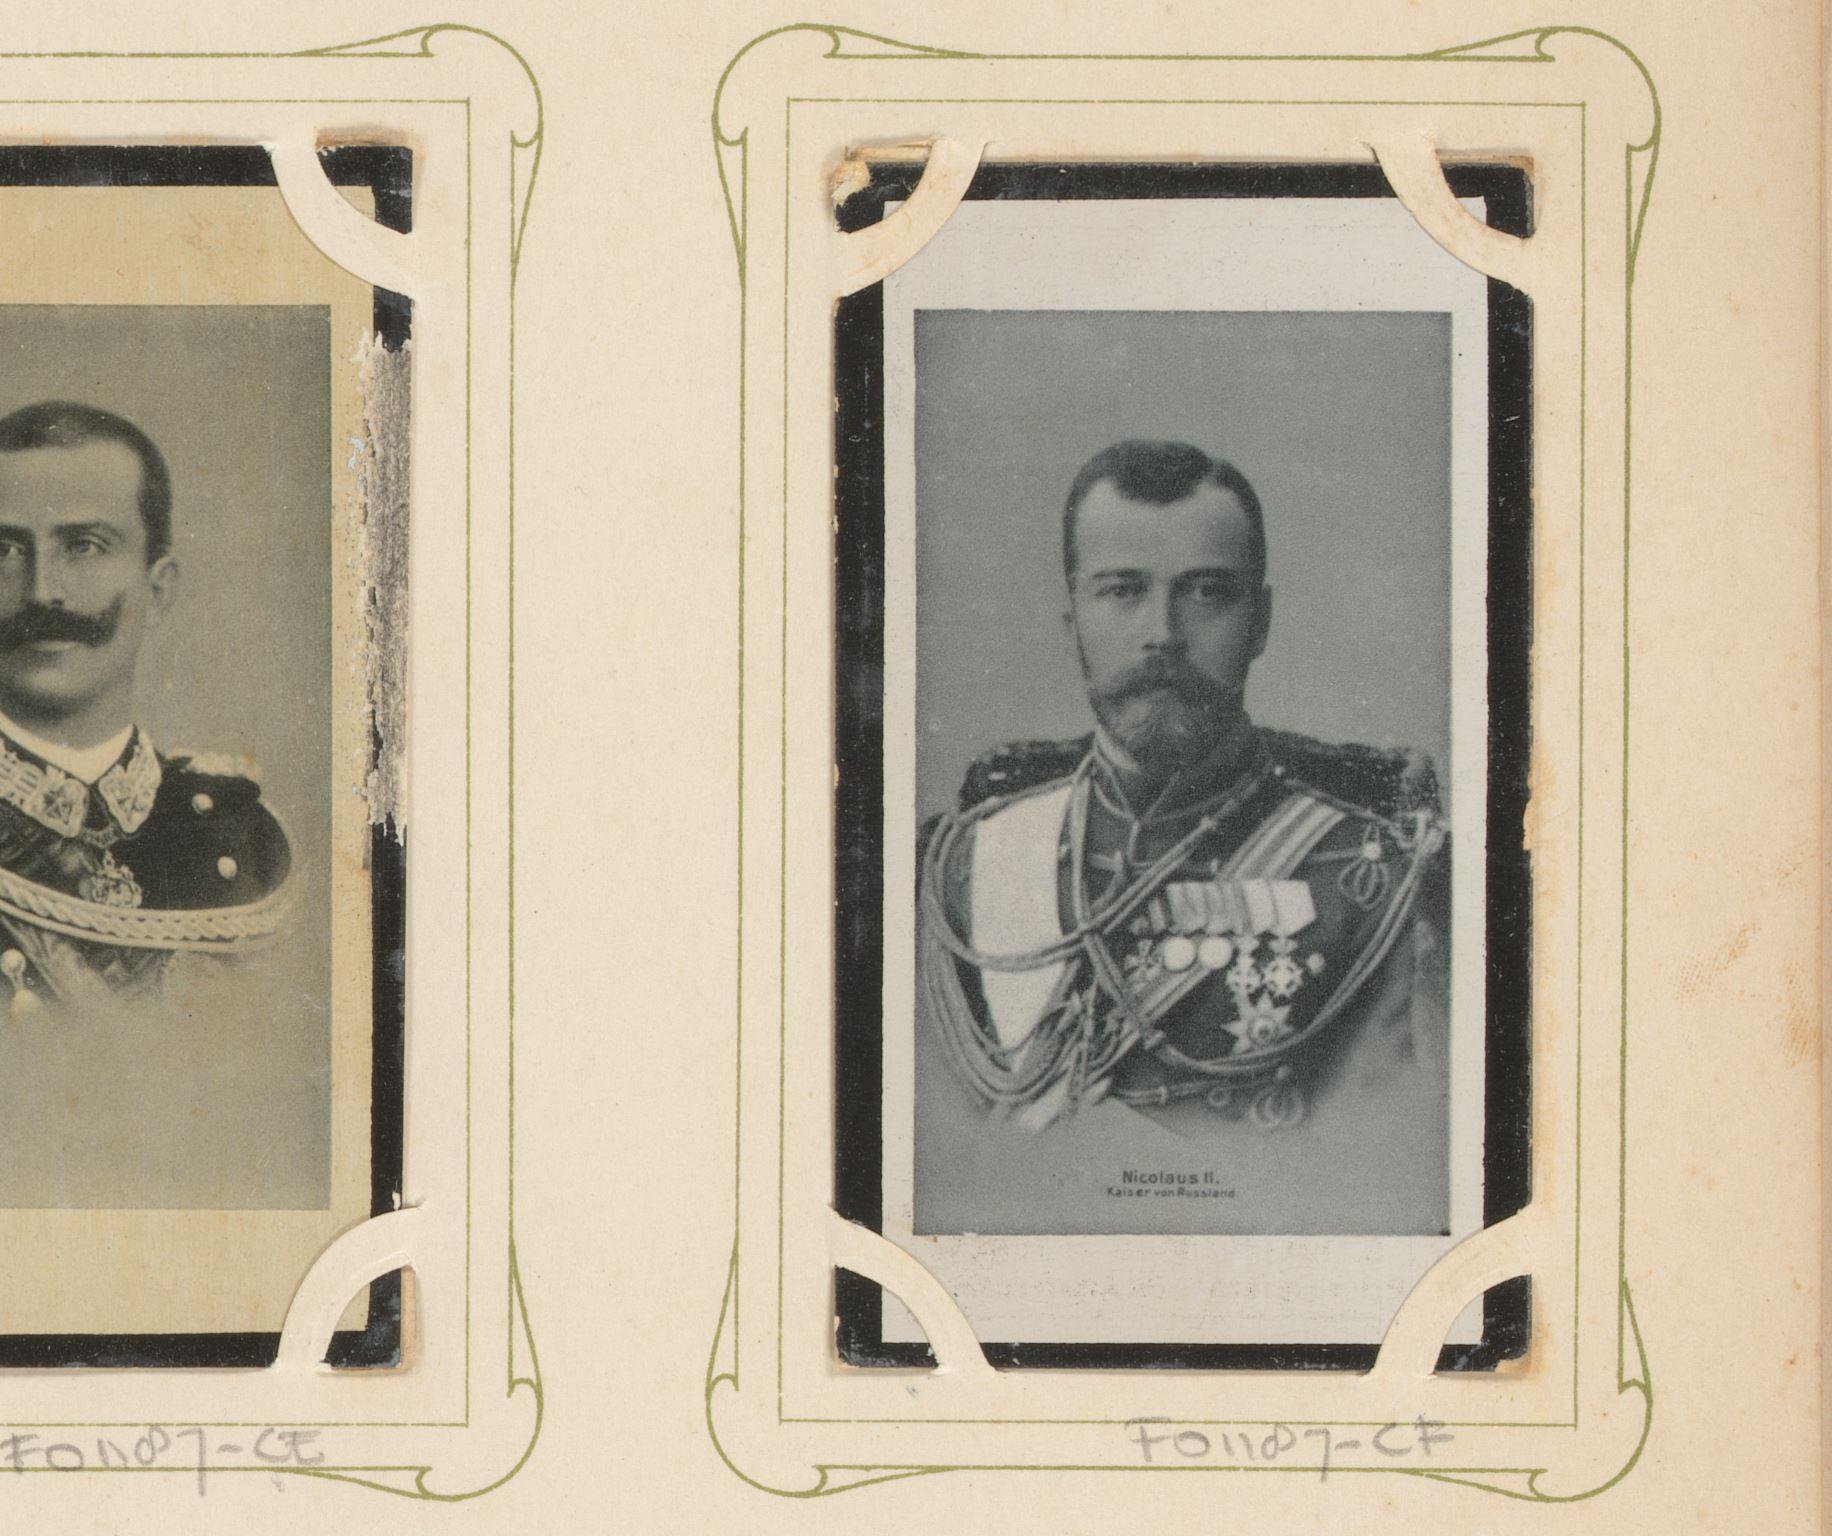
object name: photomechanical print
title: Portret van tsaar Nicolaas II van Rusland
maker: Anonymous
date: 1905-1906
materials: paper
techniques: photograph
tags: historical persons, emperor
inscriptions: inscription: ‘No. 9./ Czar Nicolaas II van Rusland.’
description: Deze prent maakt deel uit van een album.